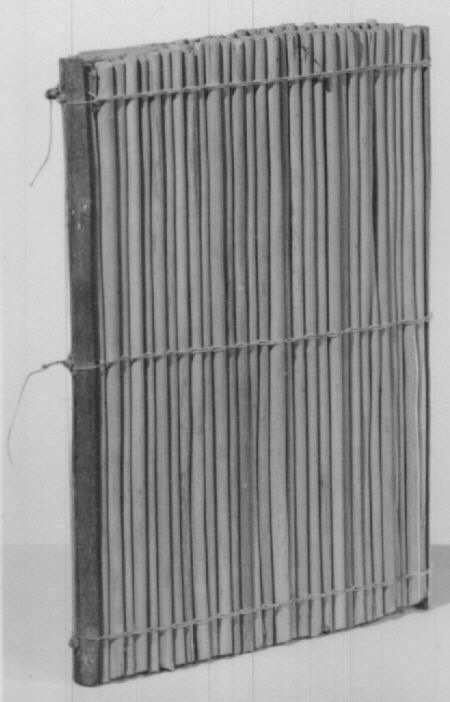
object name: vessel rattle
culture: congolese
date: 1867-1900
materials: cord